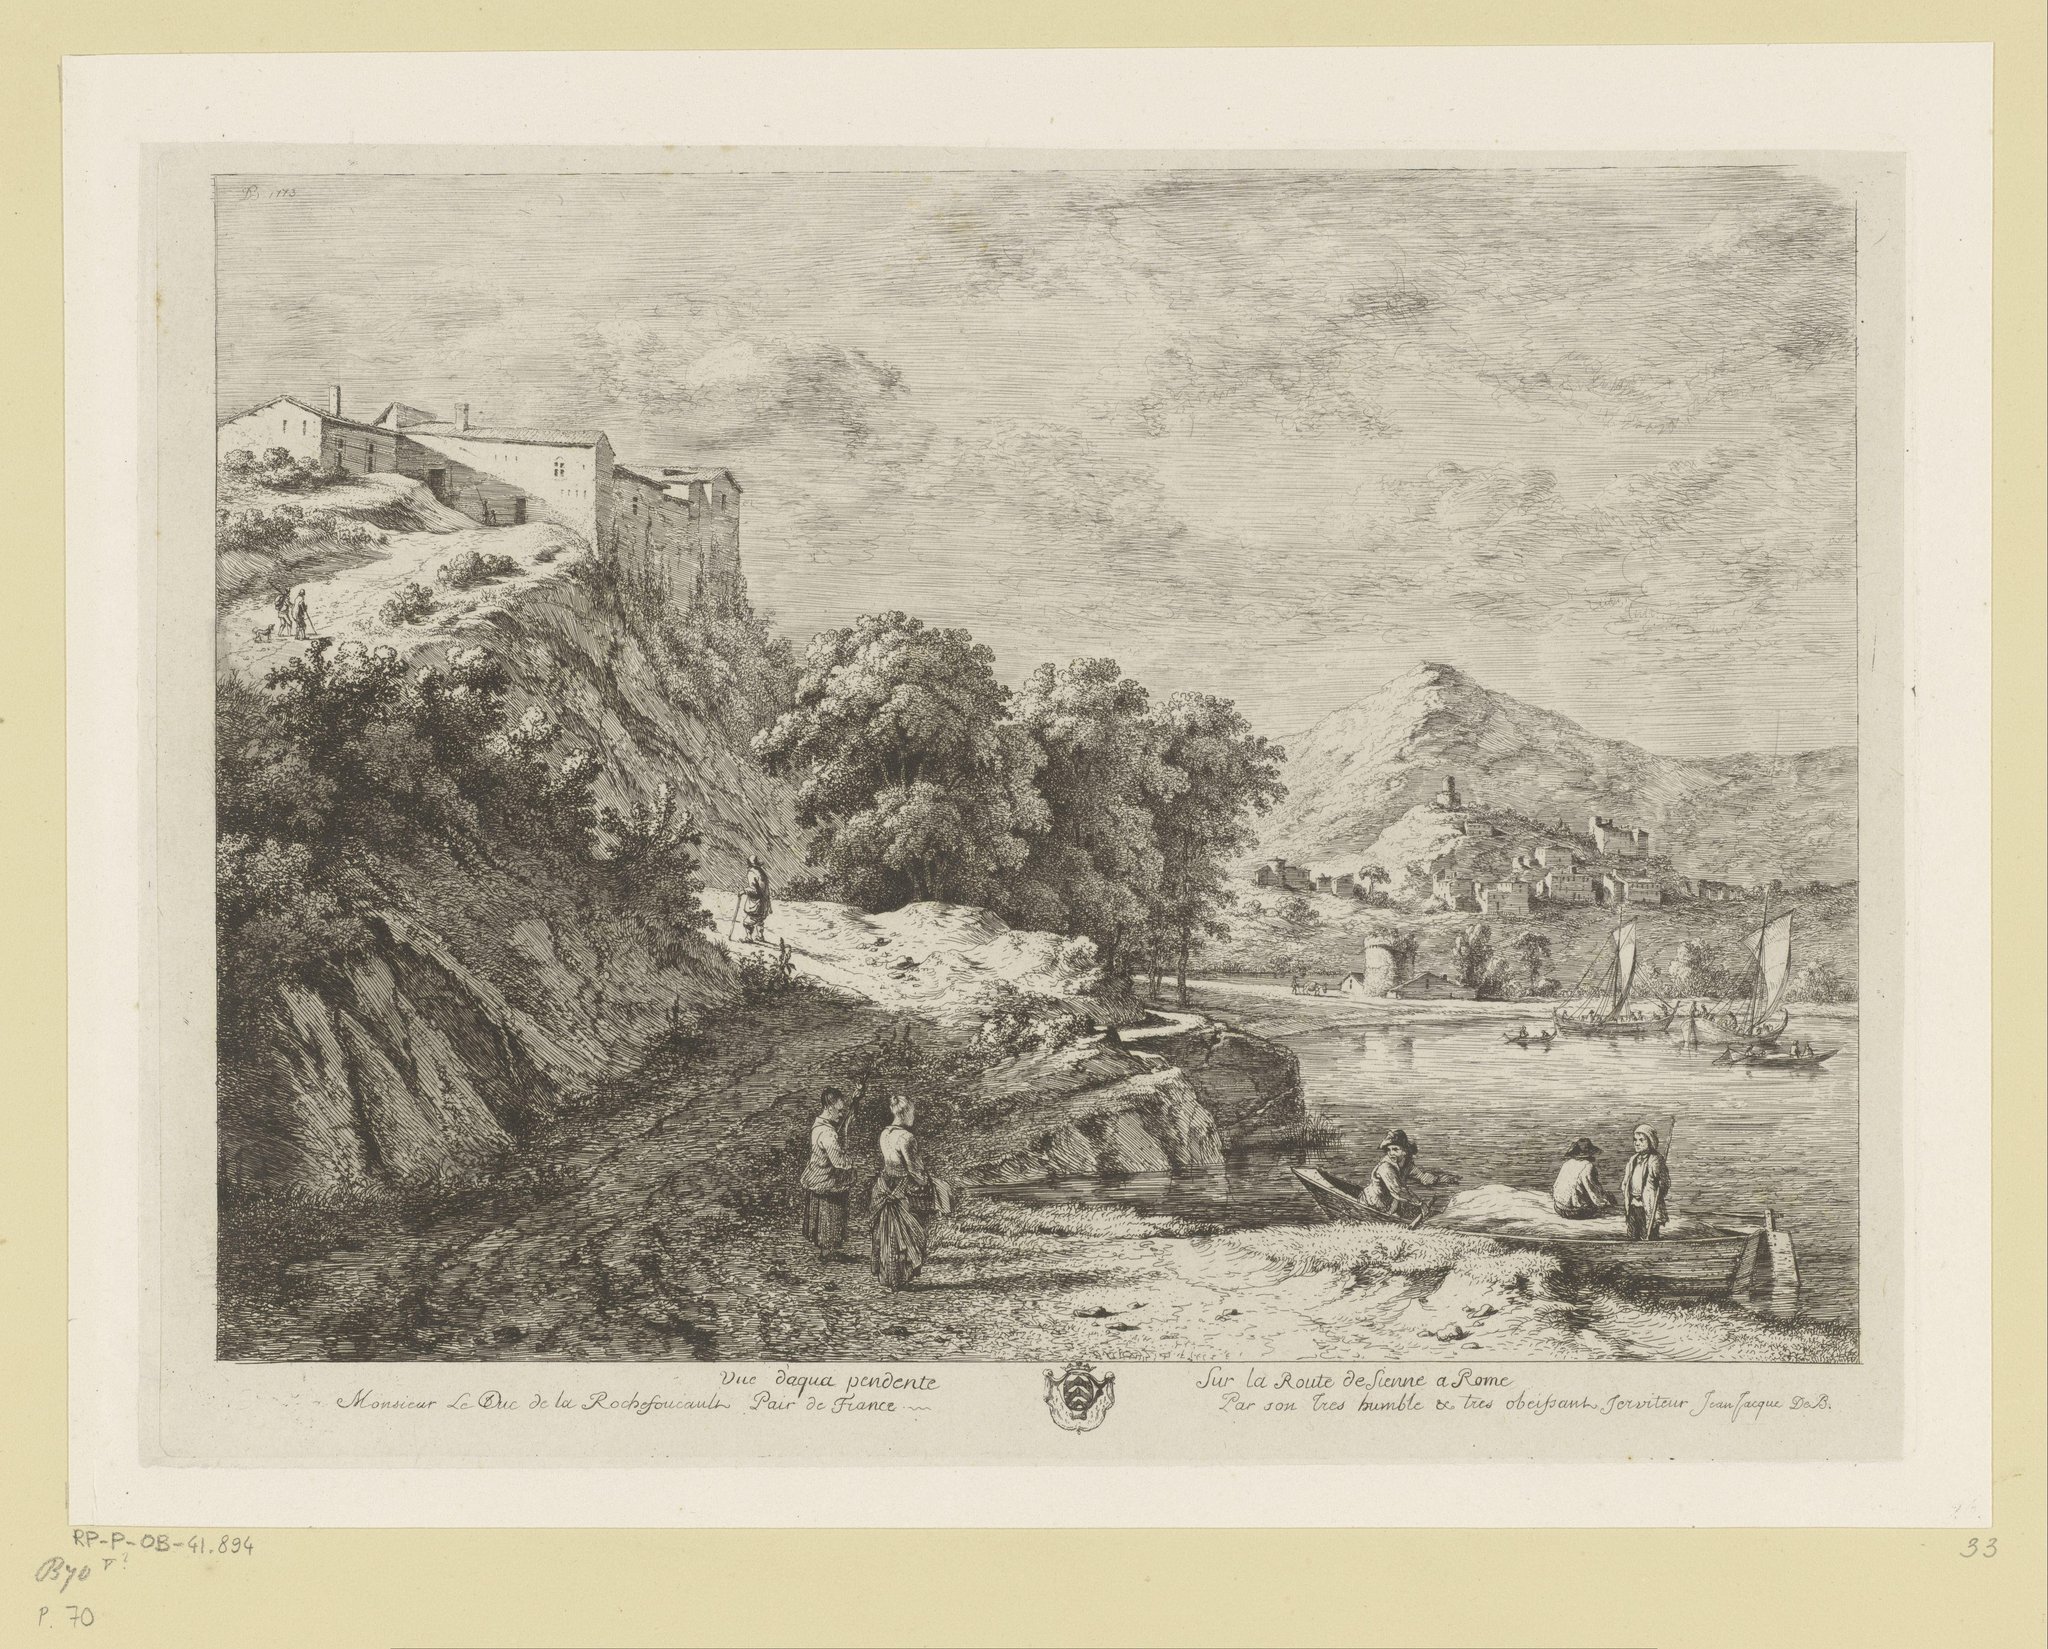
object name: print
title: Vue d'aqua pendente Sur la Route de Sienne a Rome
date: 1773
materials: paper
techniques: drypoint, etching, roulette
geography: france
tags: city-view, and landscape with man-made constructions, city-view in general; 'veduta'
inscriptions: collector's mark: Lugt 12